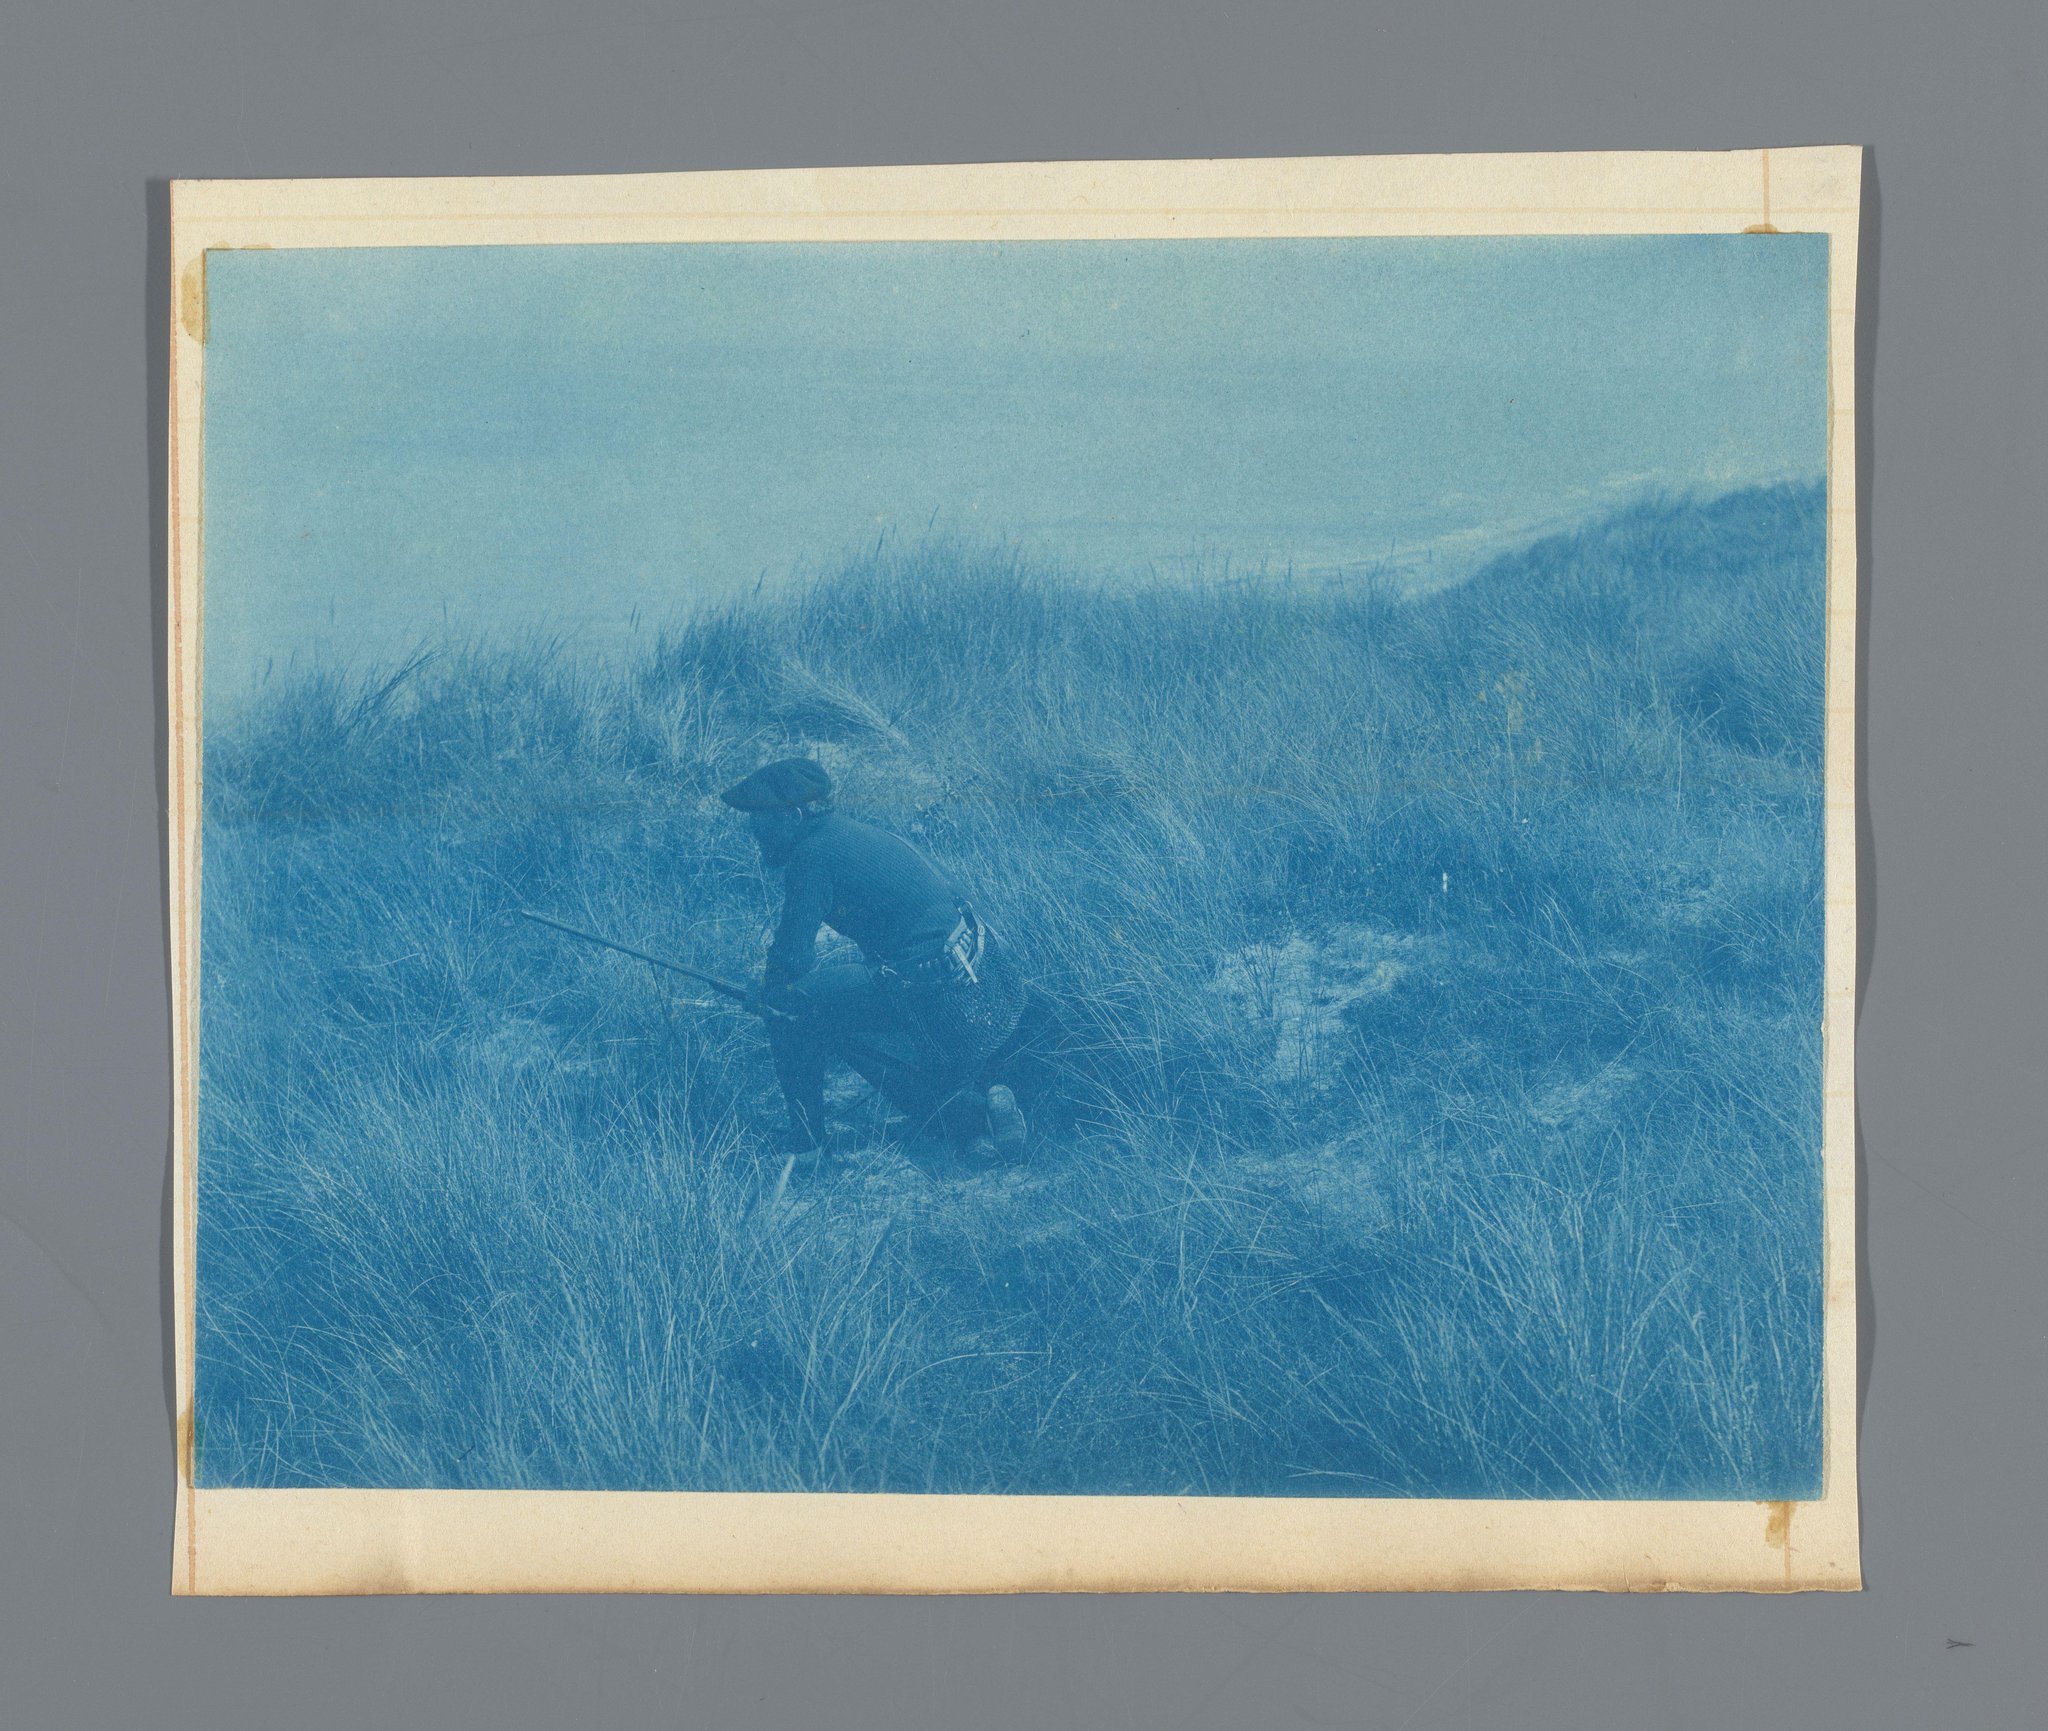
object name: photograph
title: Jager in de duinen, gebukt zittend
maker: Anonymous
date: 1880-1900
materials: paper, photographic support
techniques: cyanotype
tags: dune coast, hunting, chase